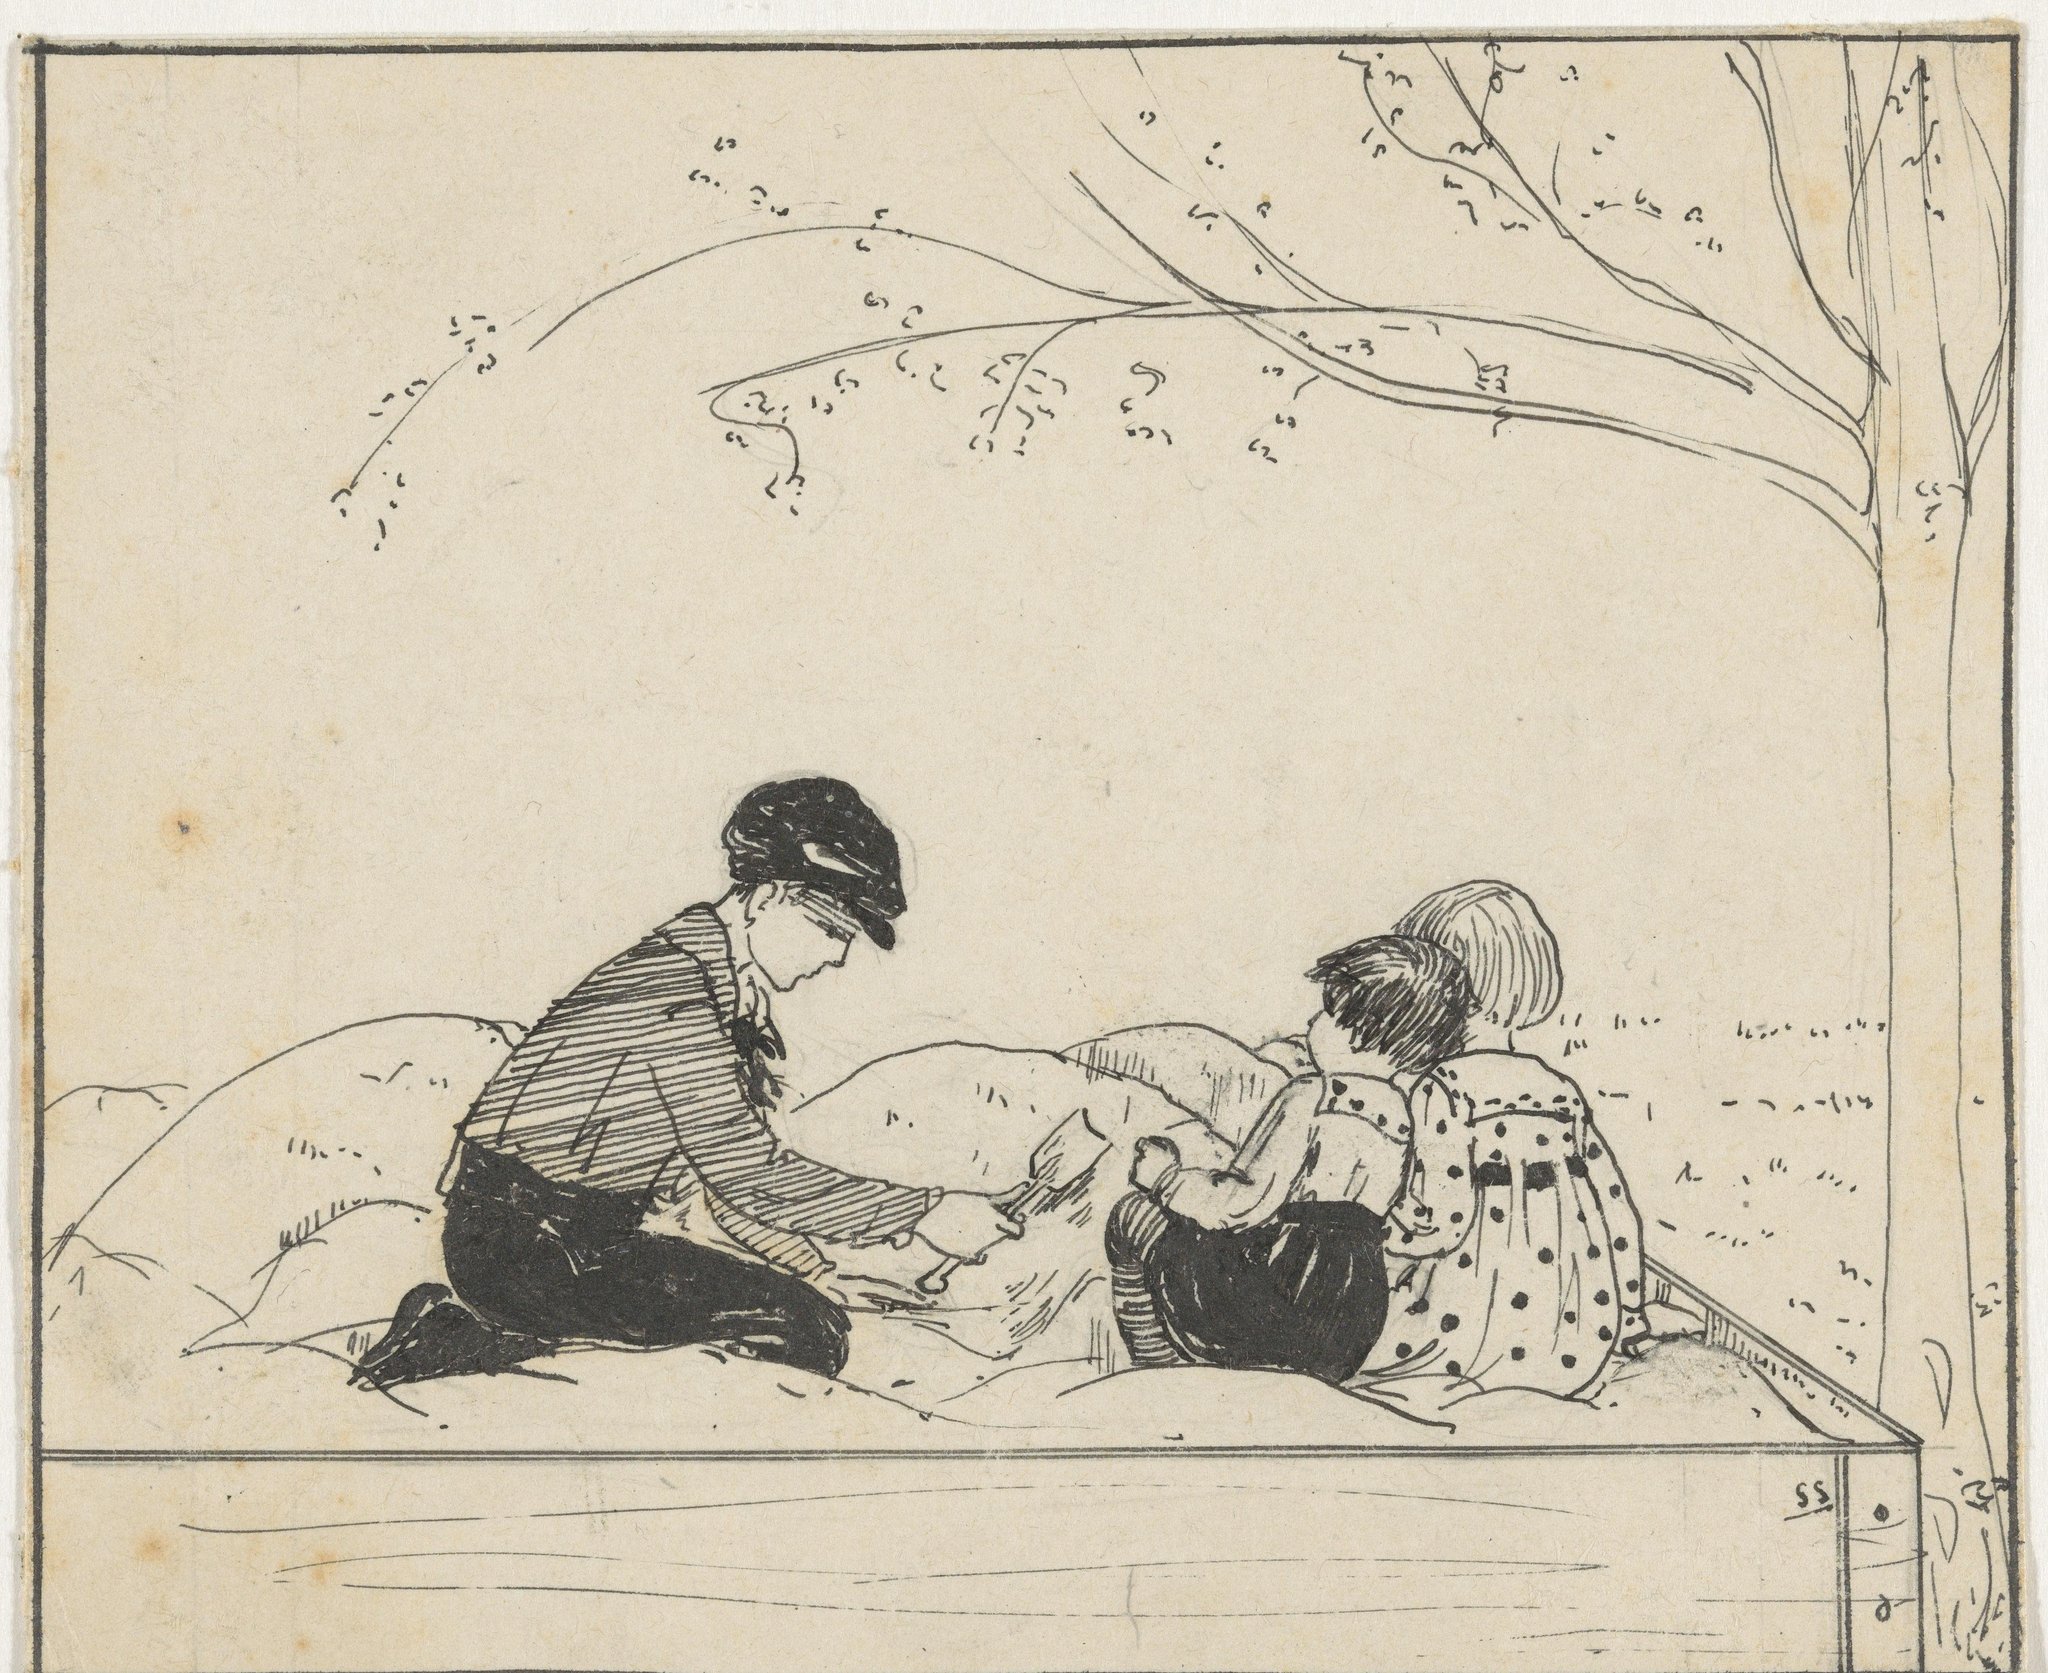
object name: drawing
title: Drie kinderen spelen in een zandbak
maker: Anonymous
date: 1880-1930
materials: cardboard, ink, pencil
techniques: brush, pen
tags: children's games and plays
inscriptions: :, signature: ‘SS’, collector's mark: Lugt 2228a